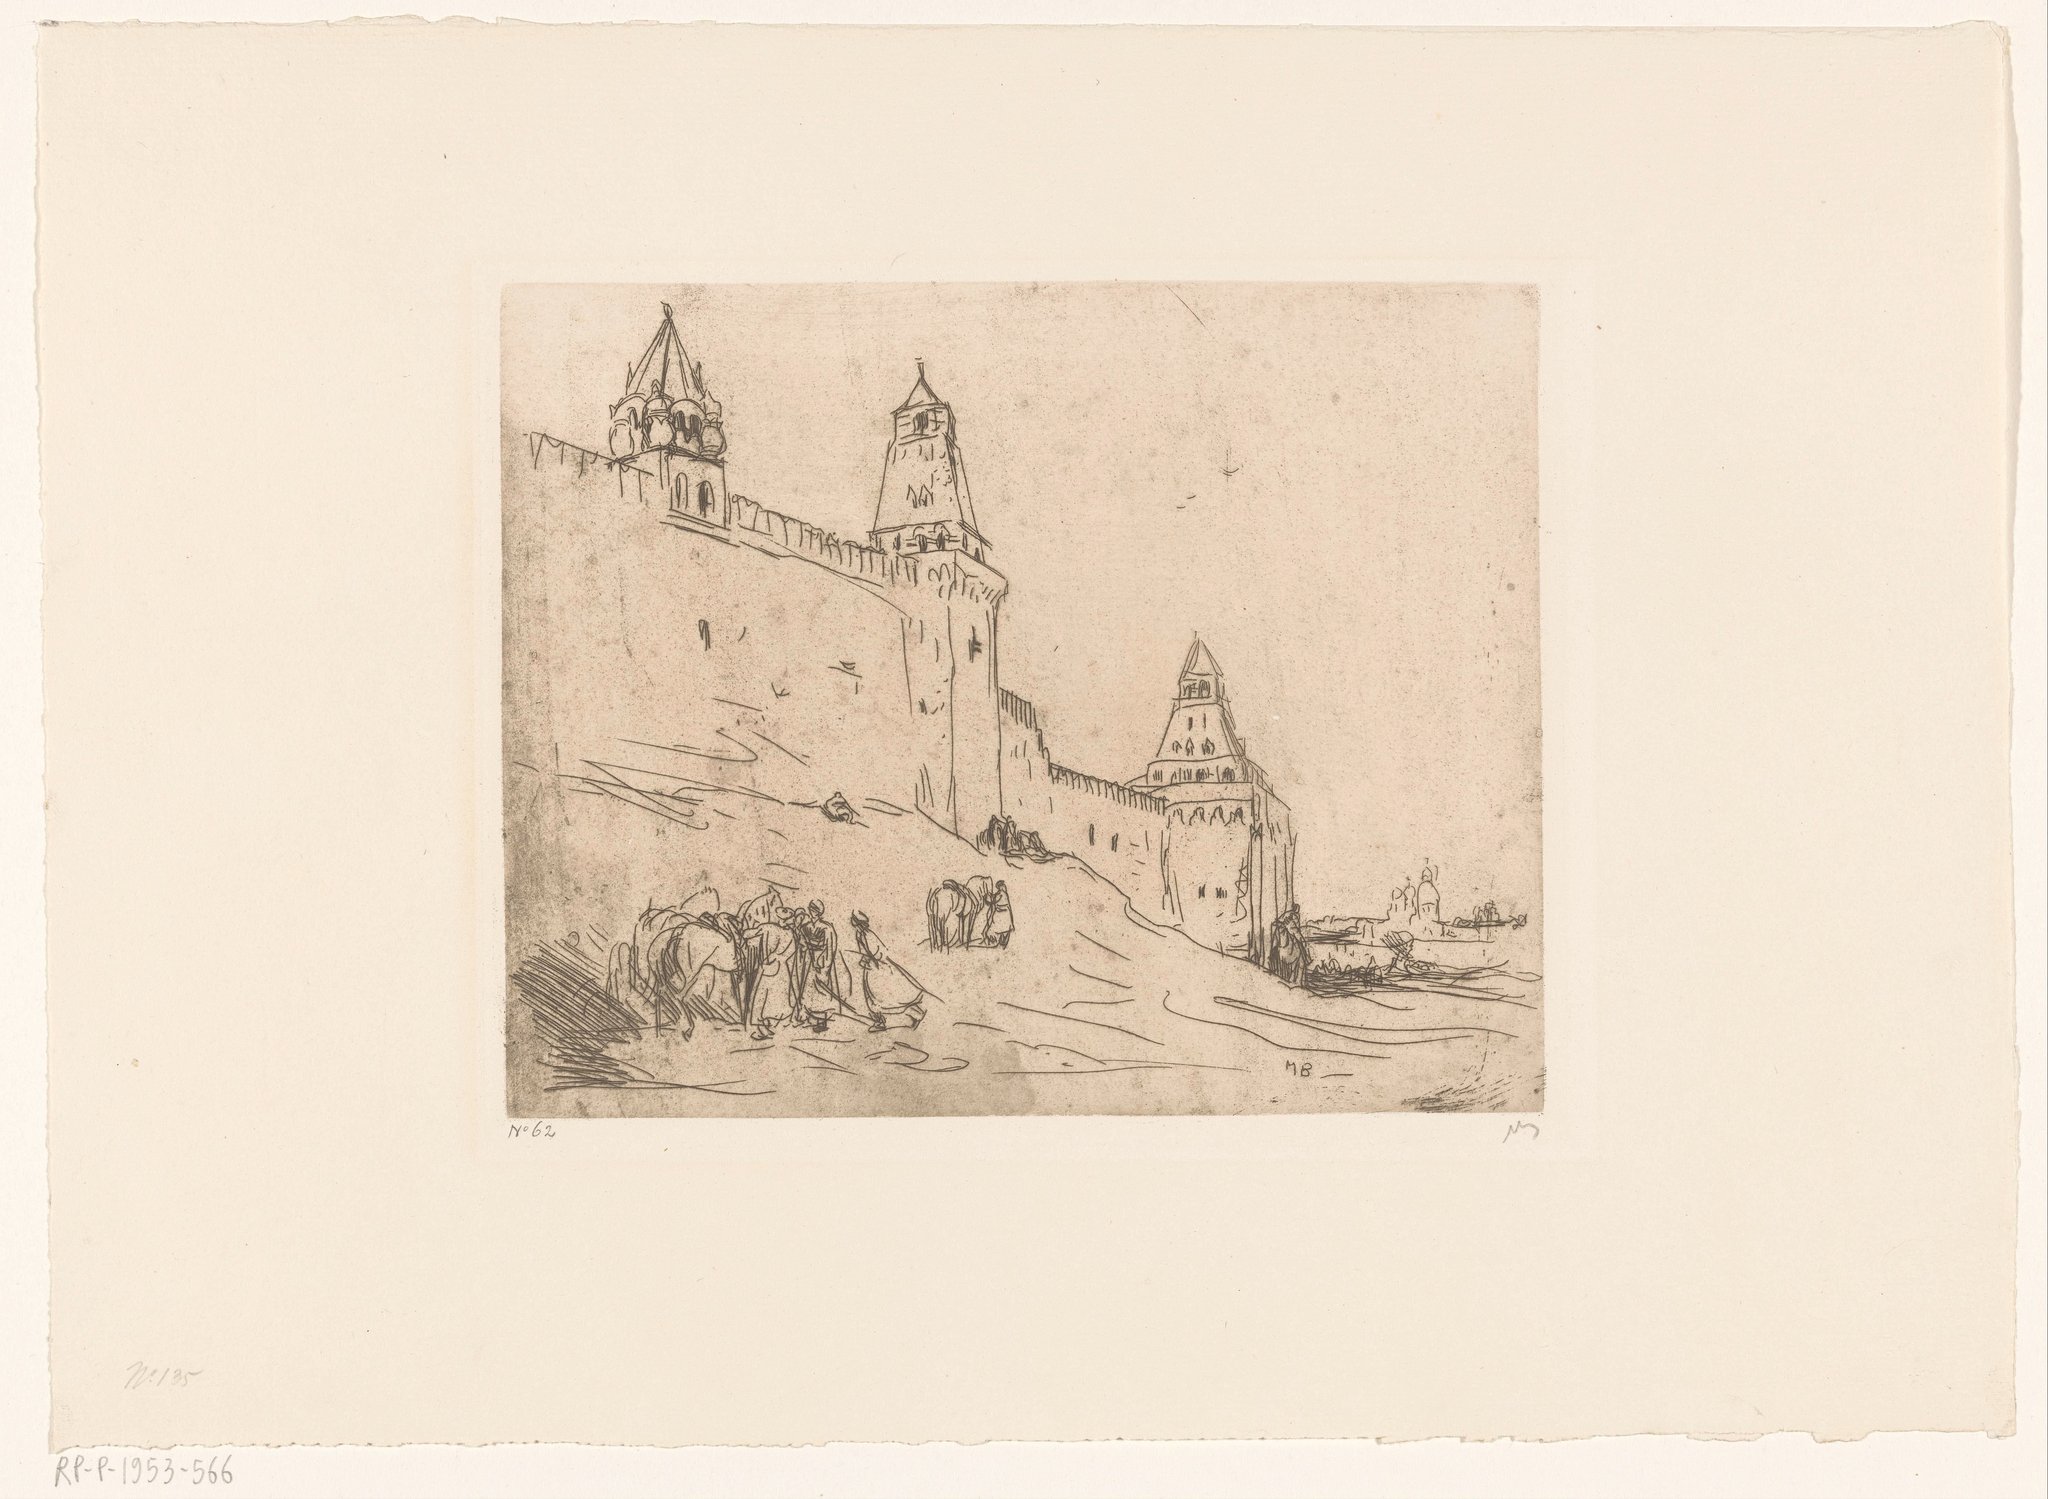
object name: print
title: Kremlin van Moskou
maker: marius bauer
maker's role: draughtsman, print maker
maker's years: 1867-1932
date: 1900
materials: paper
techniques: etching, intaglio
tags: city-walls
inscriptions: collector's mark: Lugt 2228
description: Een gedeelte van de muur van het Kremlin. Op de voorgrond figuren met paarden en op de achtergrond een kathedraal.